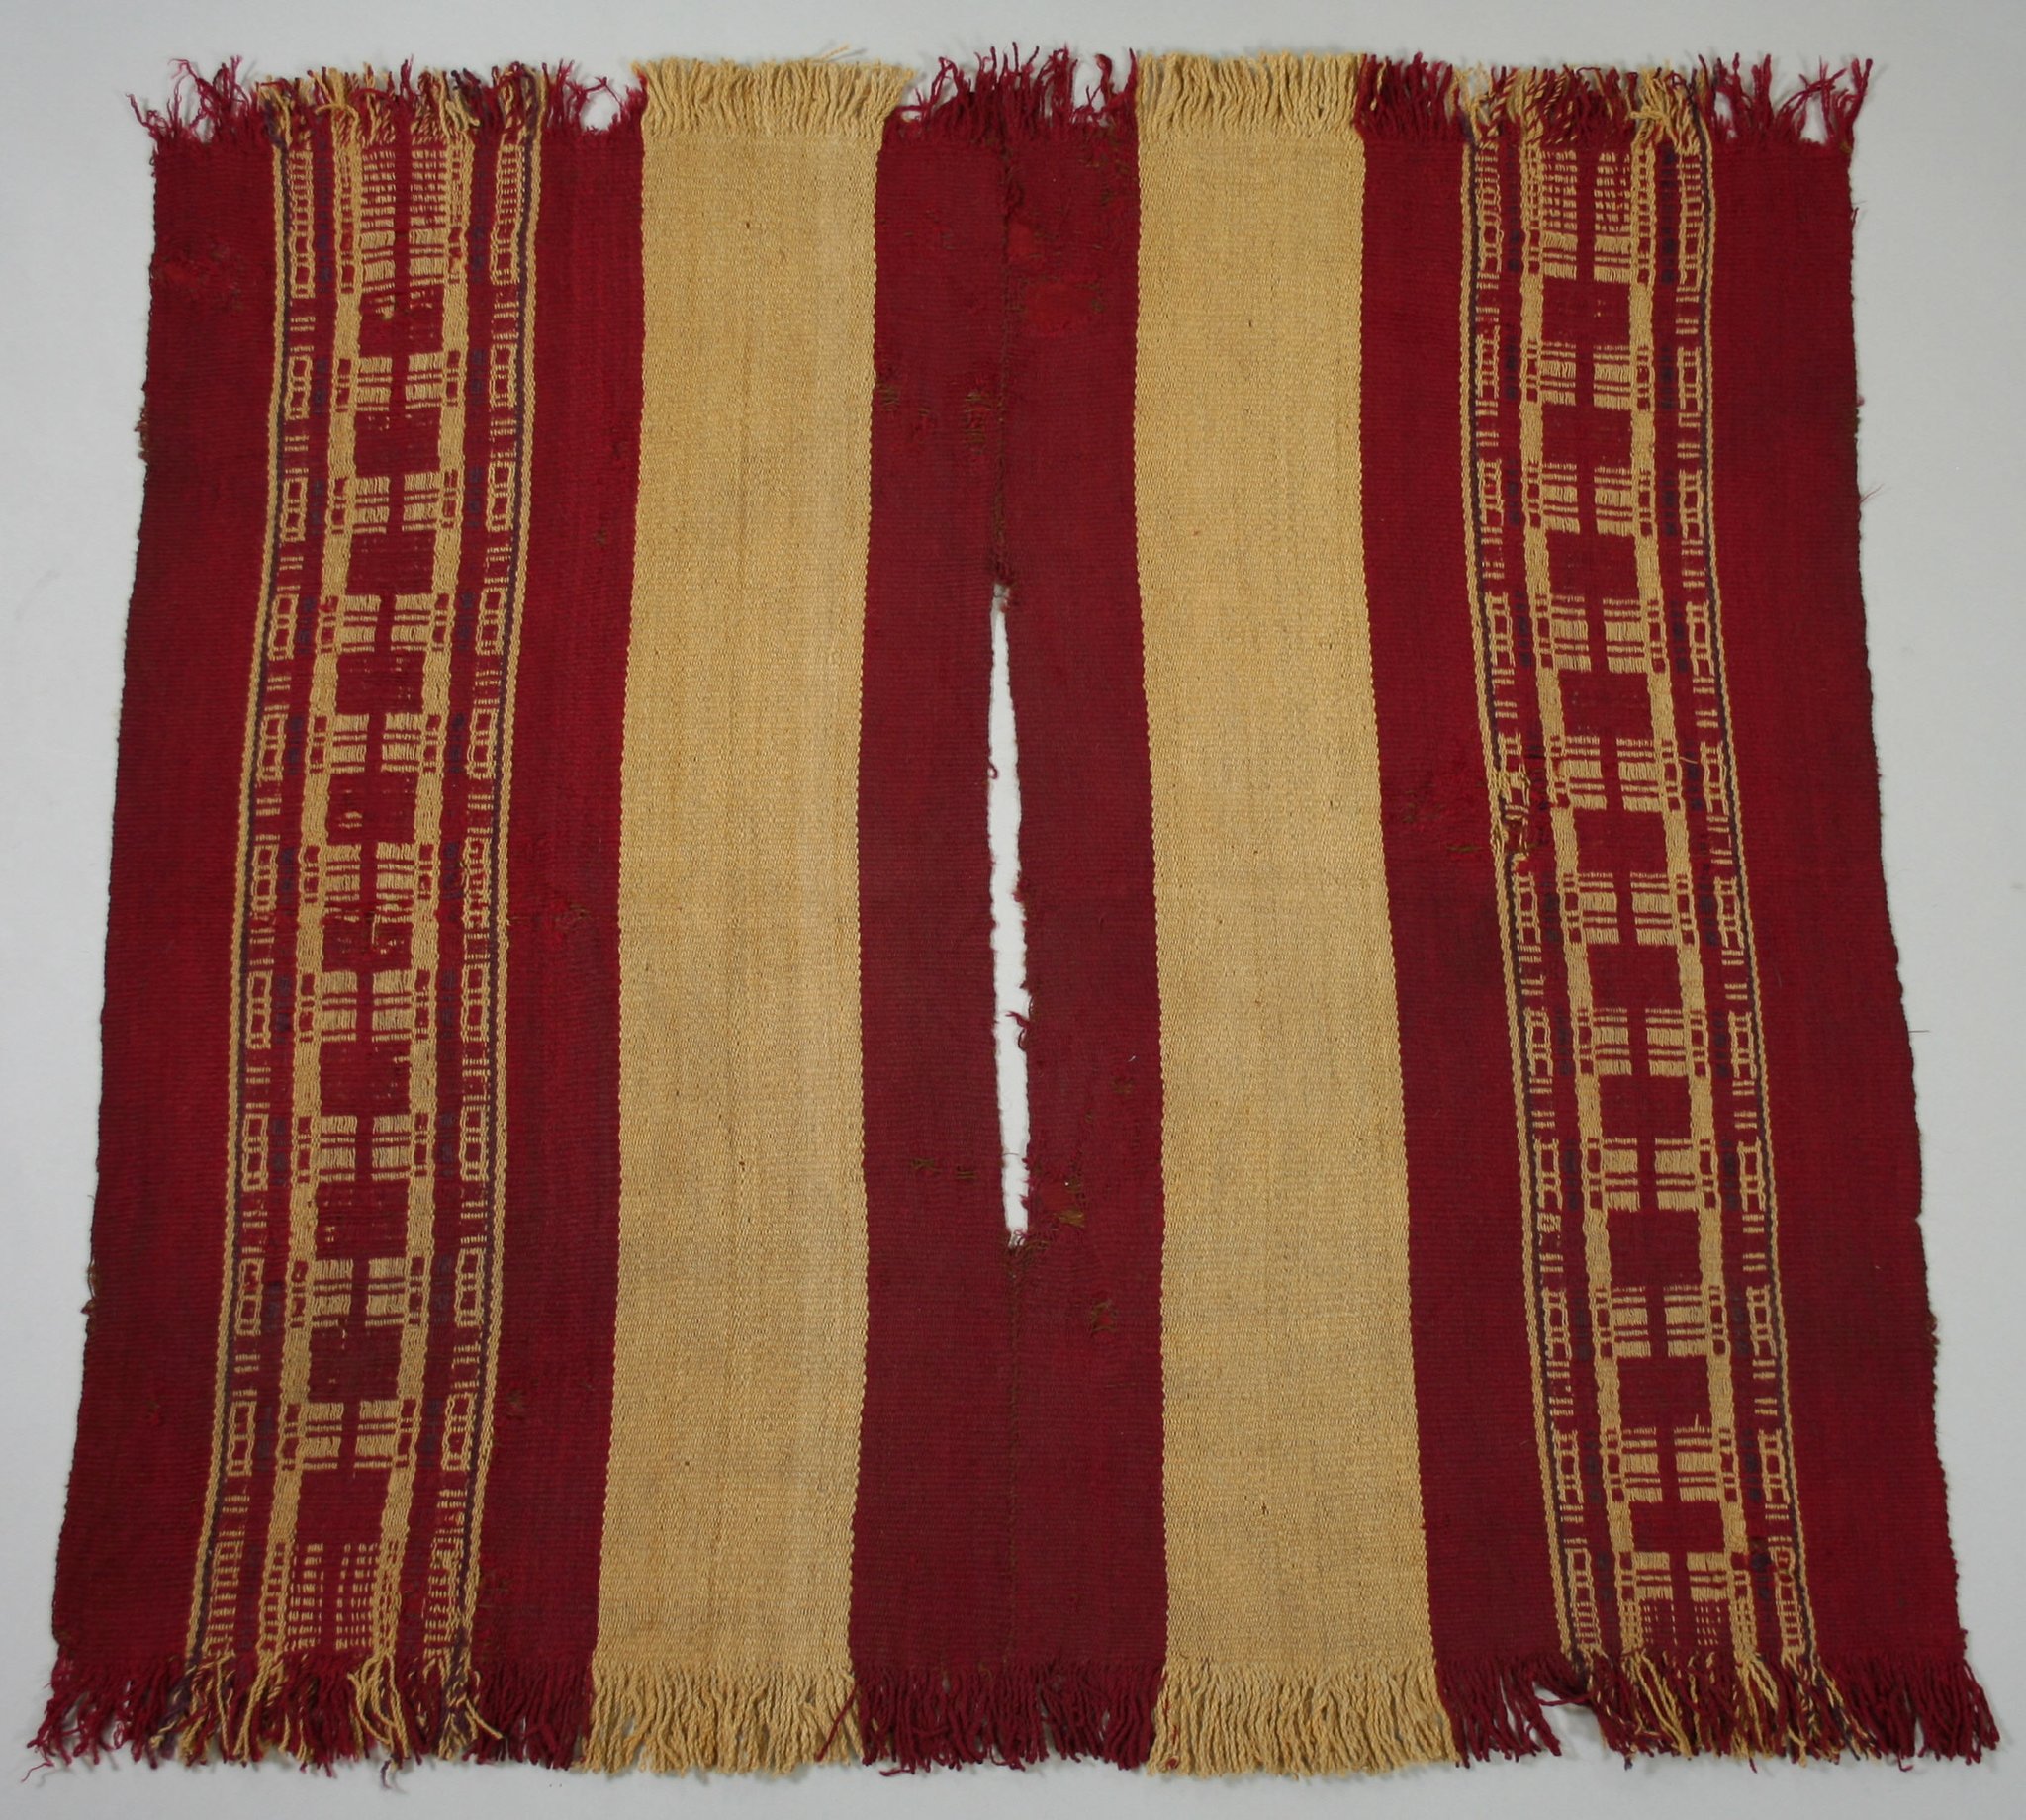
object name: garment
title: Man's Garment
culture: peruvian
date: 1401-1500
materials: animal fiber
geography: peru